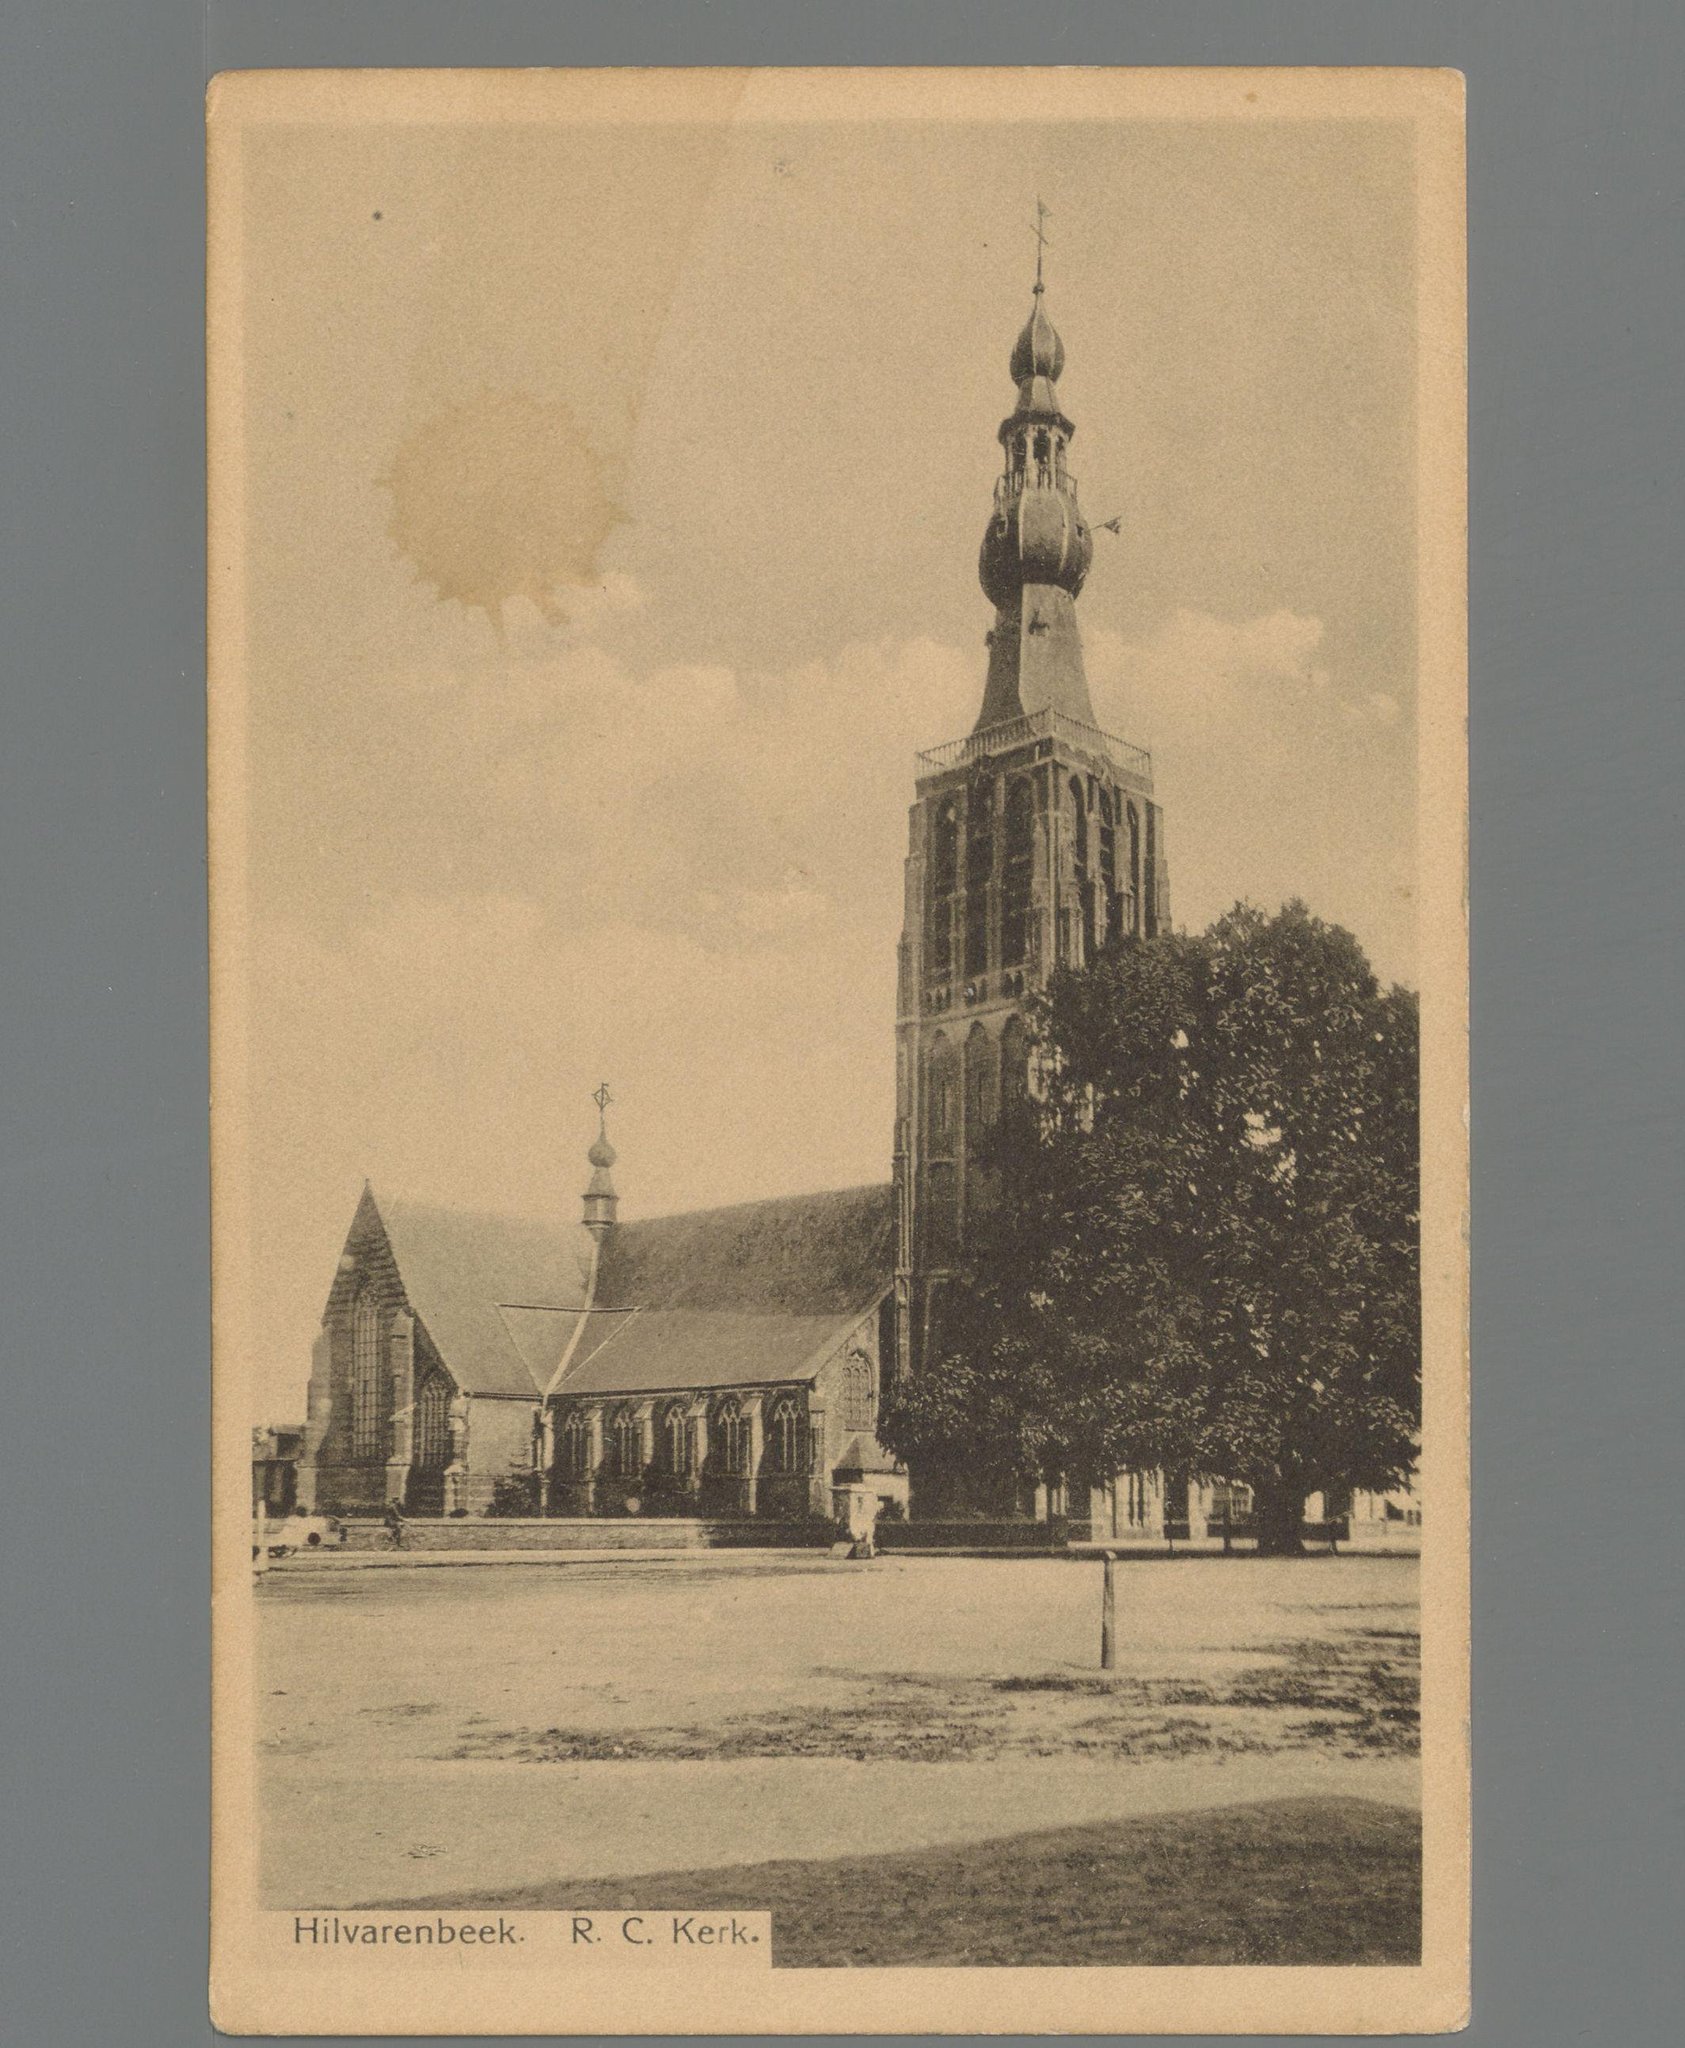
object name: ansichtkaart, prentbriefkaart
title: Hilvarenbeek. R. C. Kerk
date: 1915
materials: cardboard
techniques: photograph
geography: hilvarenbeek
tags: church (exterior)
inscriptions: monogram: ‘K.H.’